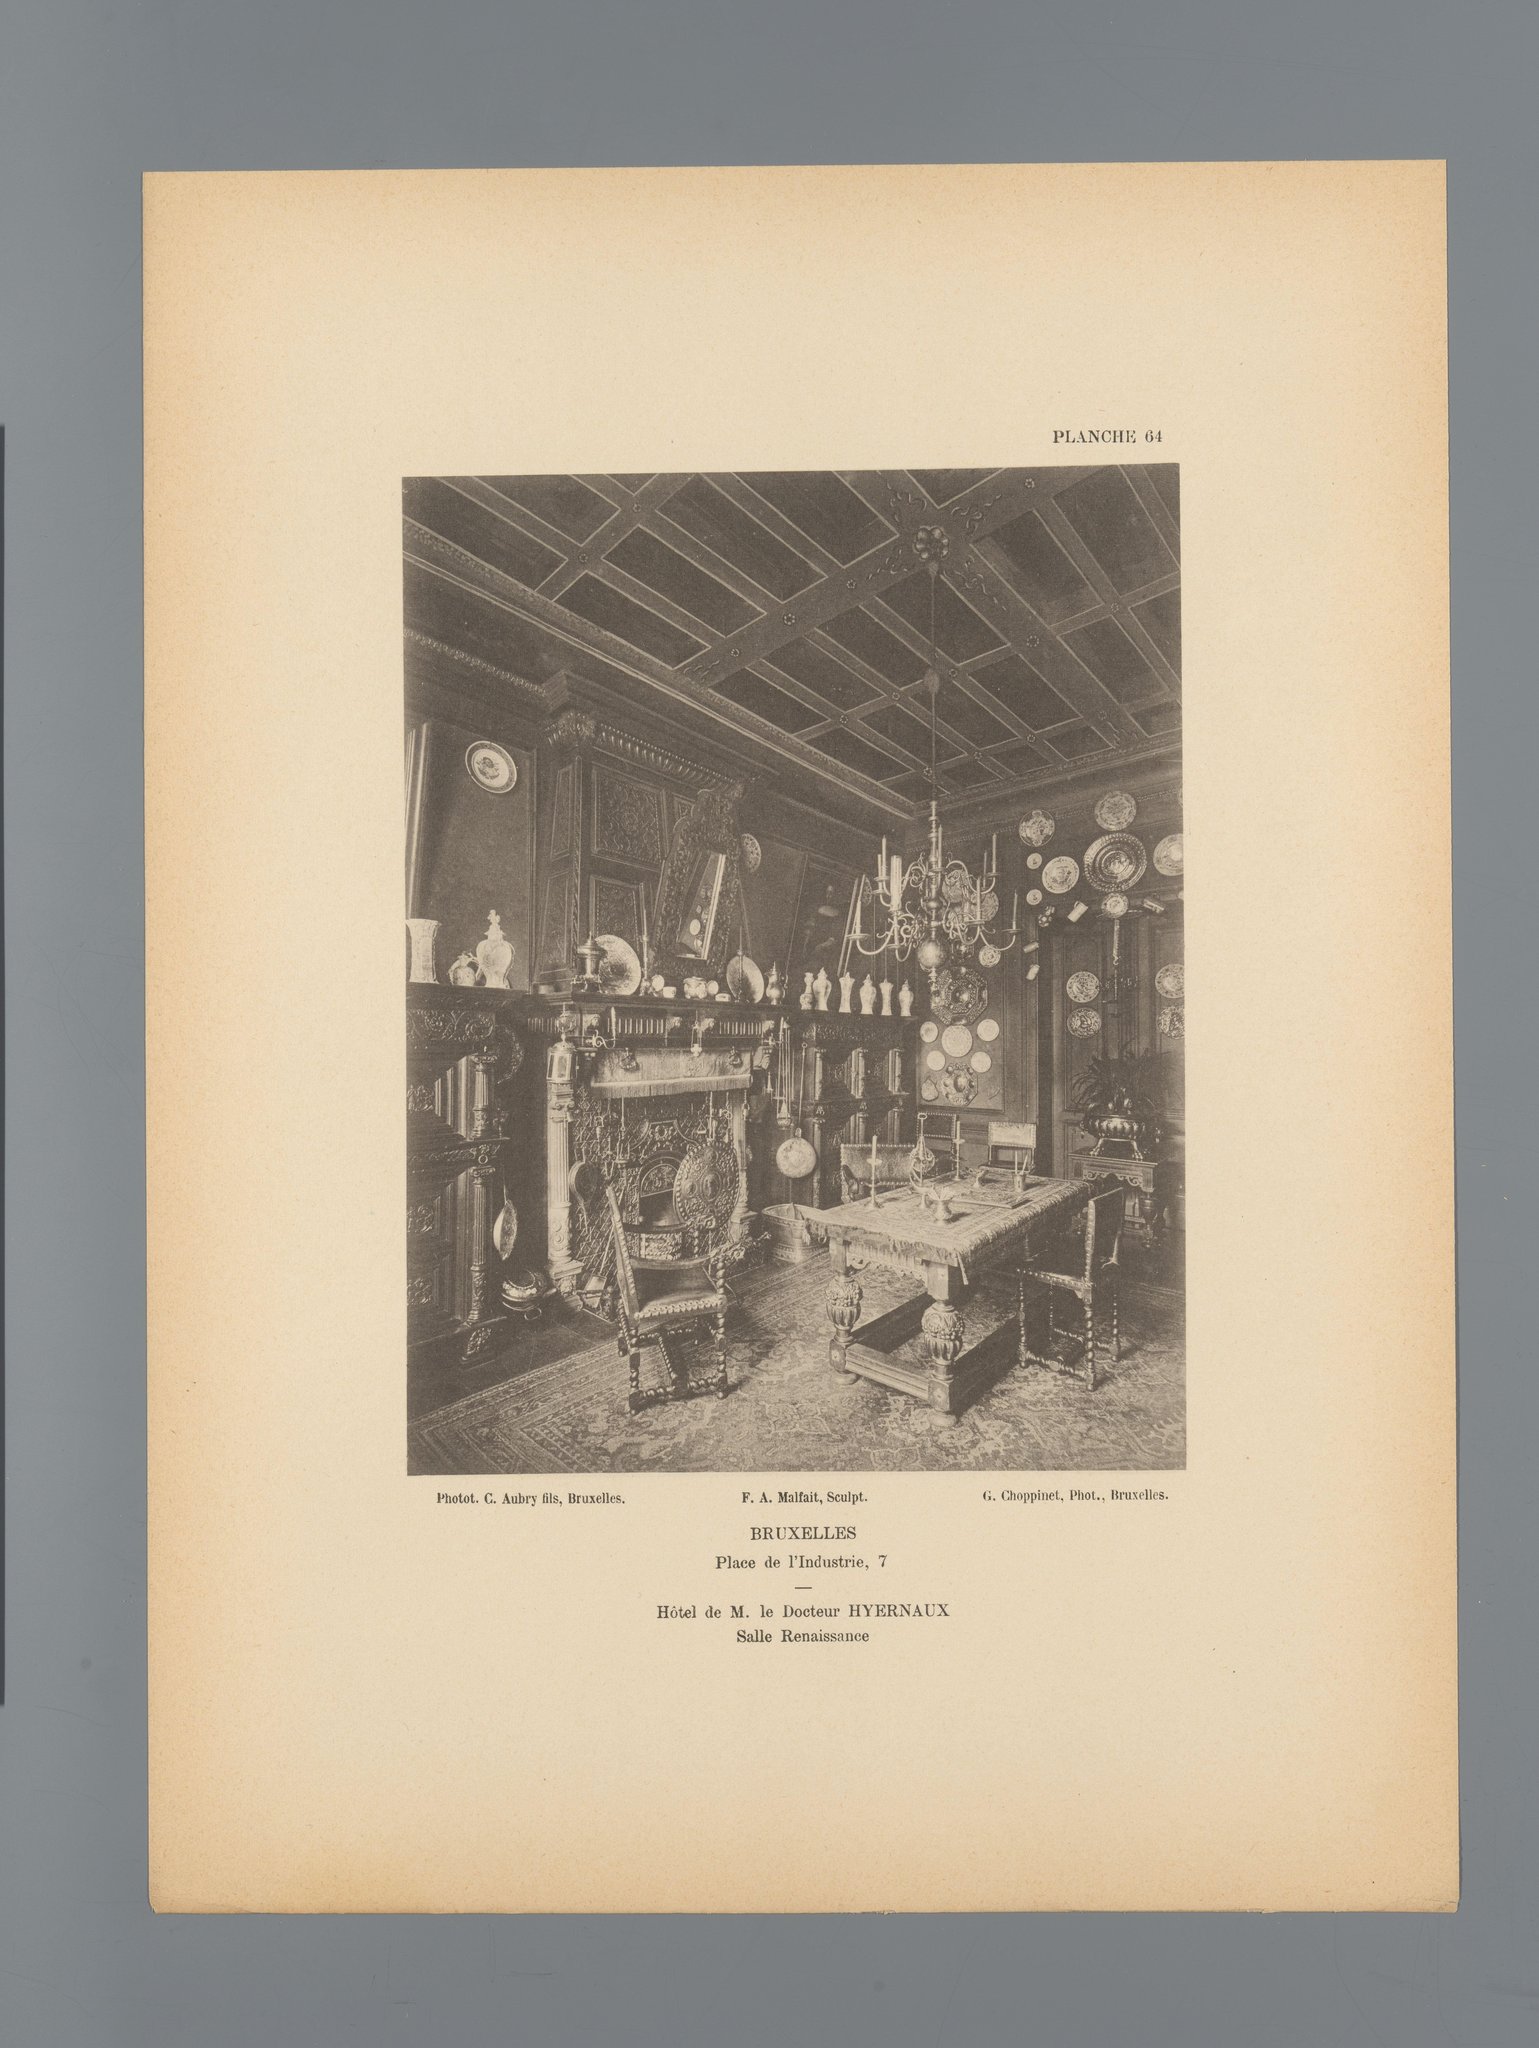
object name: photomechanical print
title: Gezicht op een zaal in renaissancestijl in het hotel van Hyernaux in Brussel, België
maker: gustave choppinet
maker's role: fotograaf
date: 1893-1898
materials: paper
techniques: photograph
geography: brussels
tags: interior of the house, hotel, hostelry, inn, brussels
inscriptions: number: ‘PLANCHE 64’, inscription: ‘Place de l'Industrie, 7/ Hôtel de M. le Docteur HYERNAUX/ Salle Renaissance’, name: ‘F. A. Malfait, Sculpt.’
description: Deze prent maakt deel uit van een omslag met 89 prenten en 5 tekstbladen.